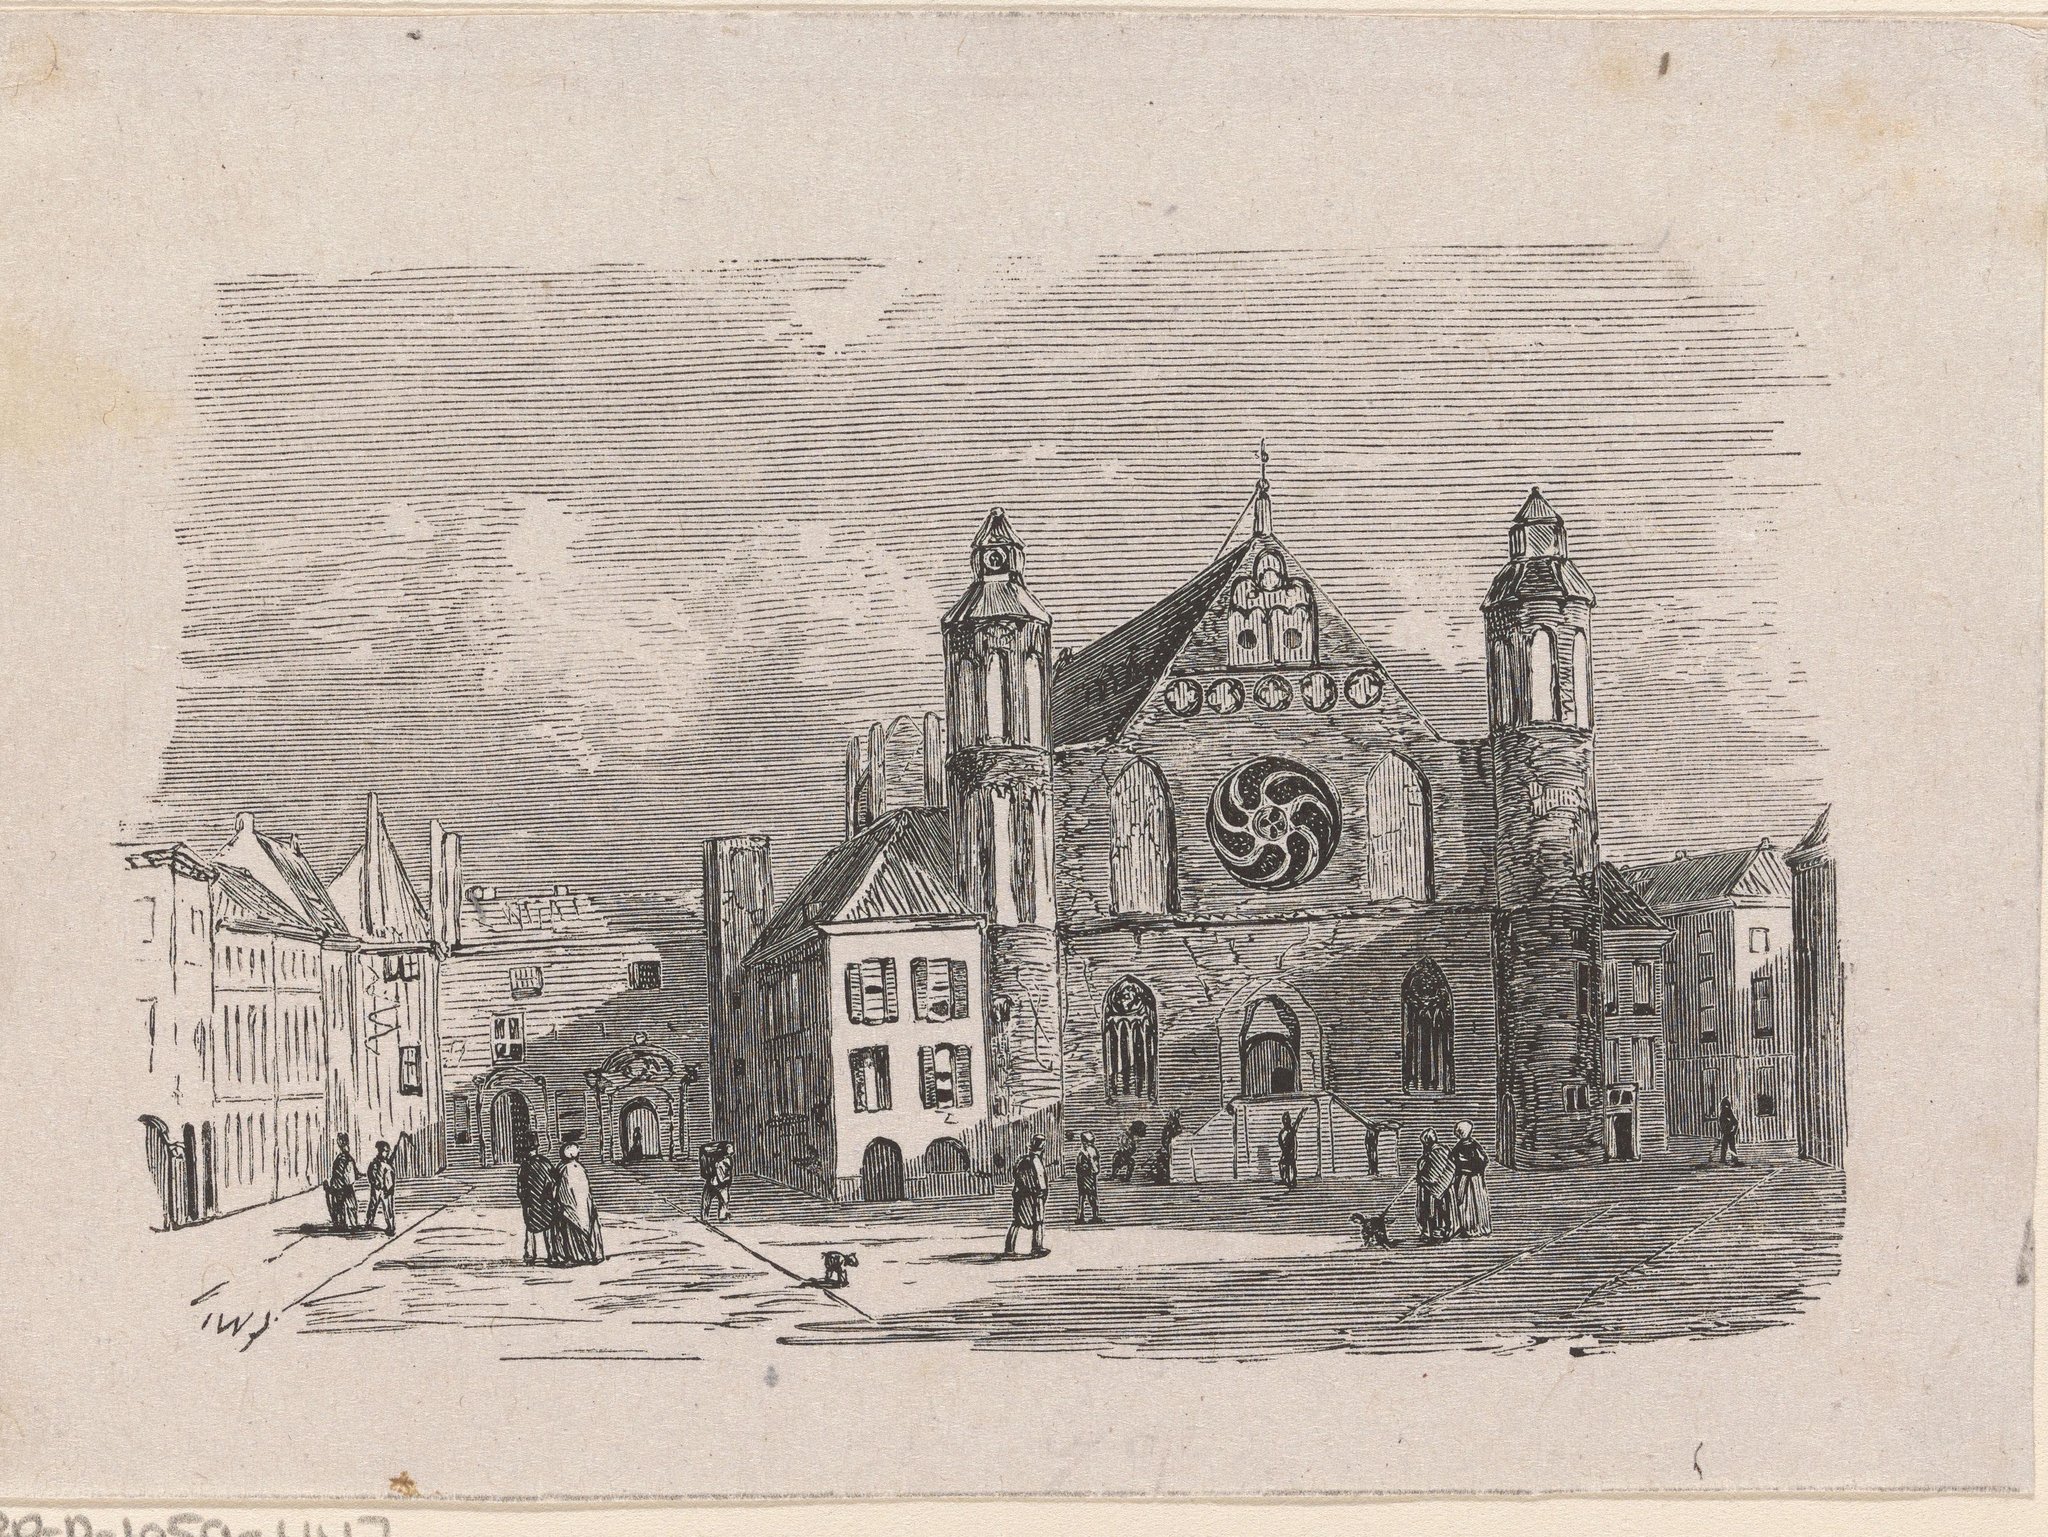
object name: print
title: Gezicht op de Ridderzaal te Den Haag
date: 1836-1912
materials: paper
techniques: engraving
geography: netherlands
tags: square, place, circus, etc. (+ city(-scape) with figures, staffage)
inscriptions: collector's mark: Lugt 2228